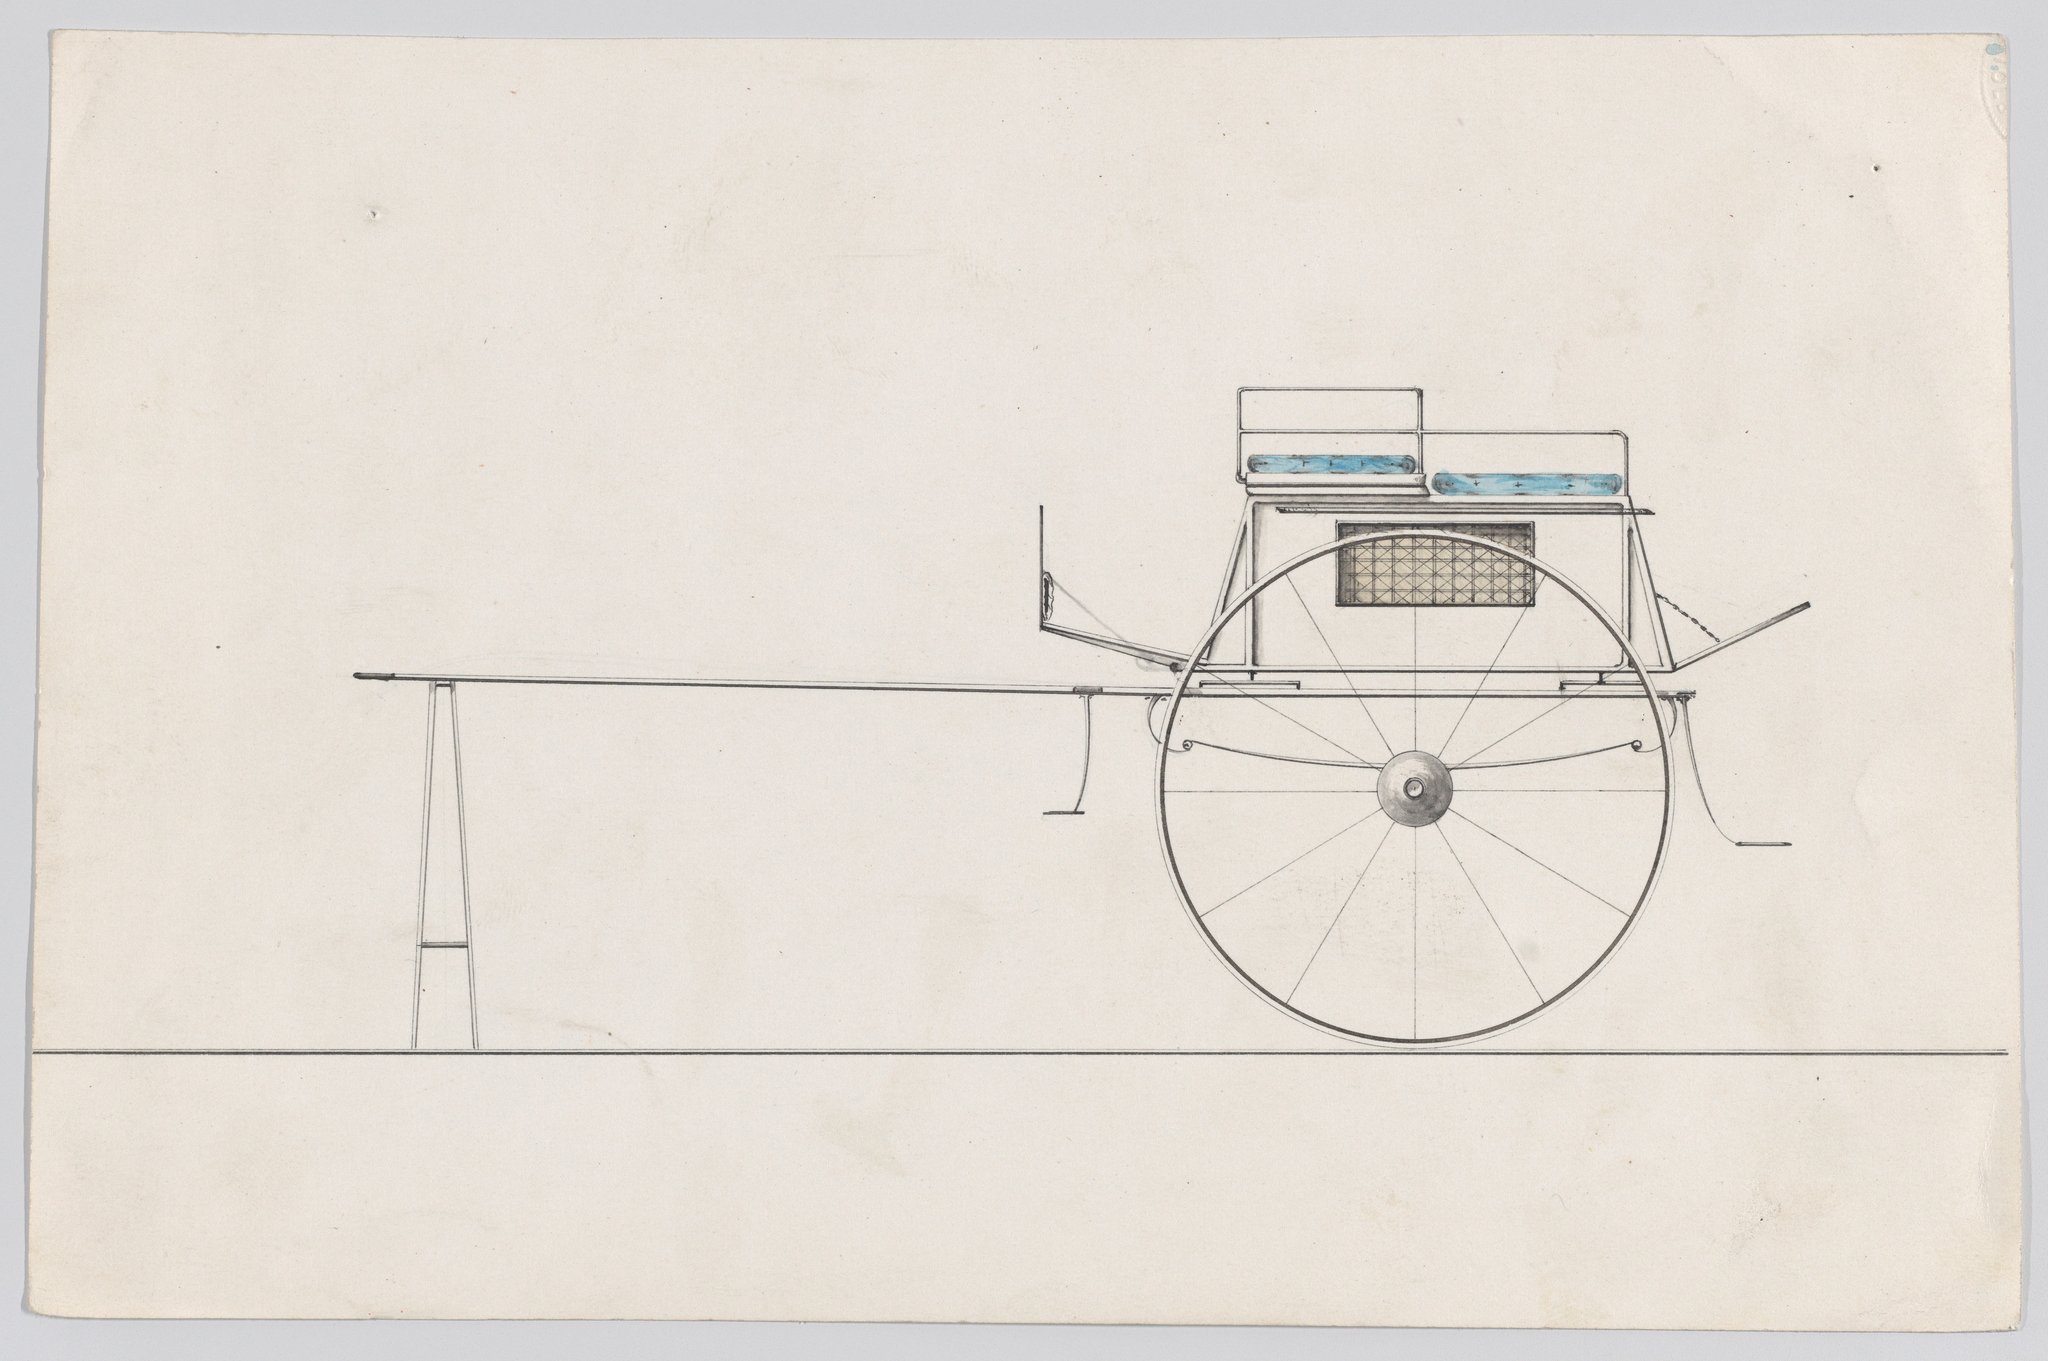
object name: drawing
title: Design for Dog Cart (French?)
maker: anonymous, french, 19th century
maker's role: artist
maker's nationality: french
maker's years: 1800-1900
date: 1880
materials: gouache, ink, watercolor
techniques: pen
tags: carriages